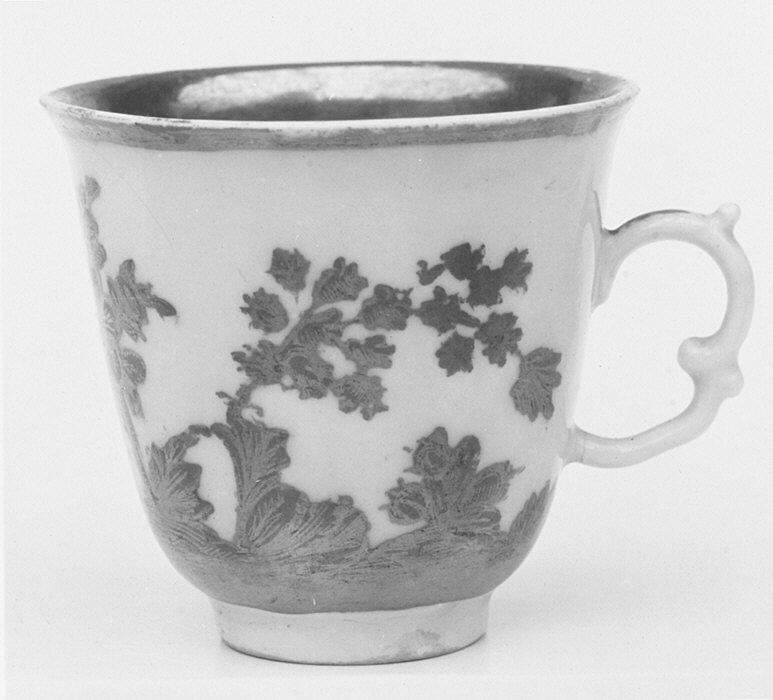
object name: cup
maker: meissen manufactory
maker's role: manufactory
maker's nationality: german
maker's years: 1710-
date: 1740-1750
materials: hard paste porcelain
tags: flowers